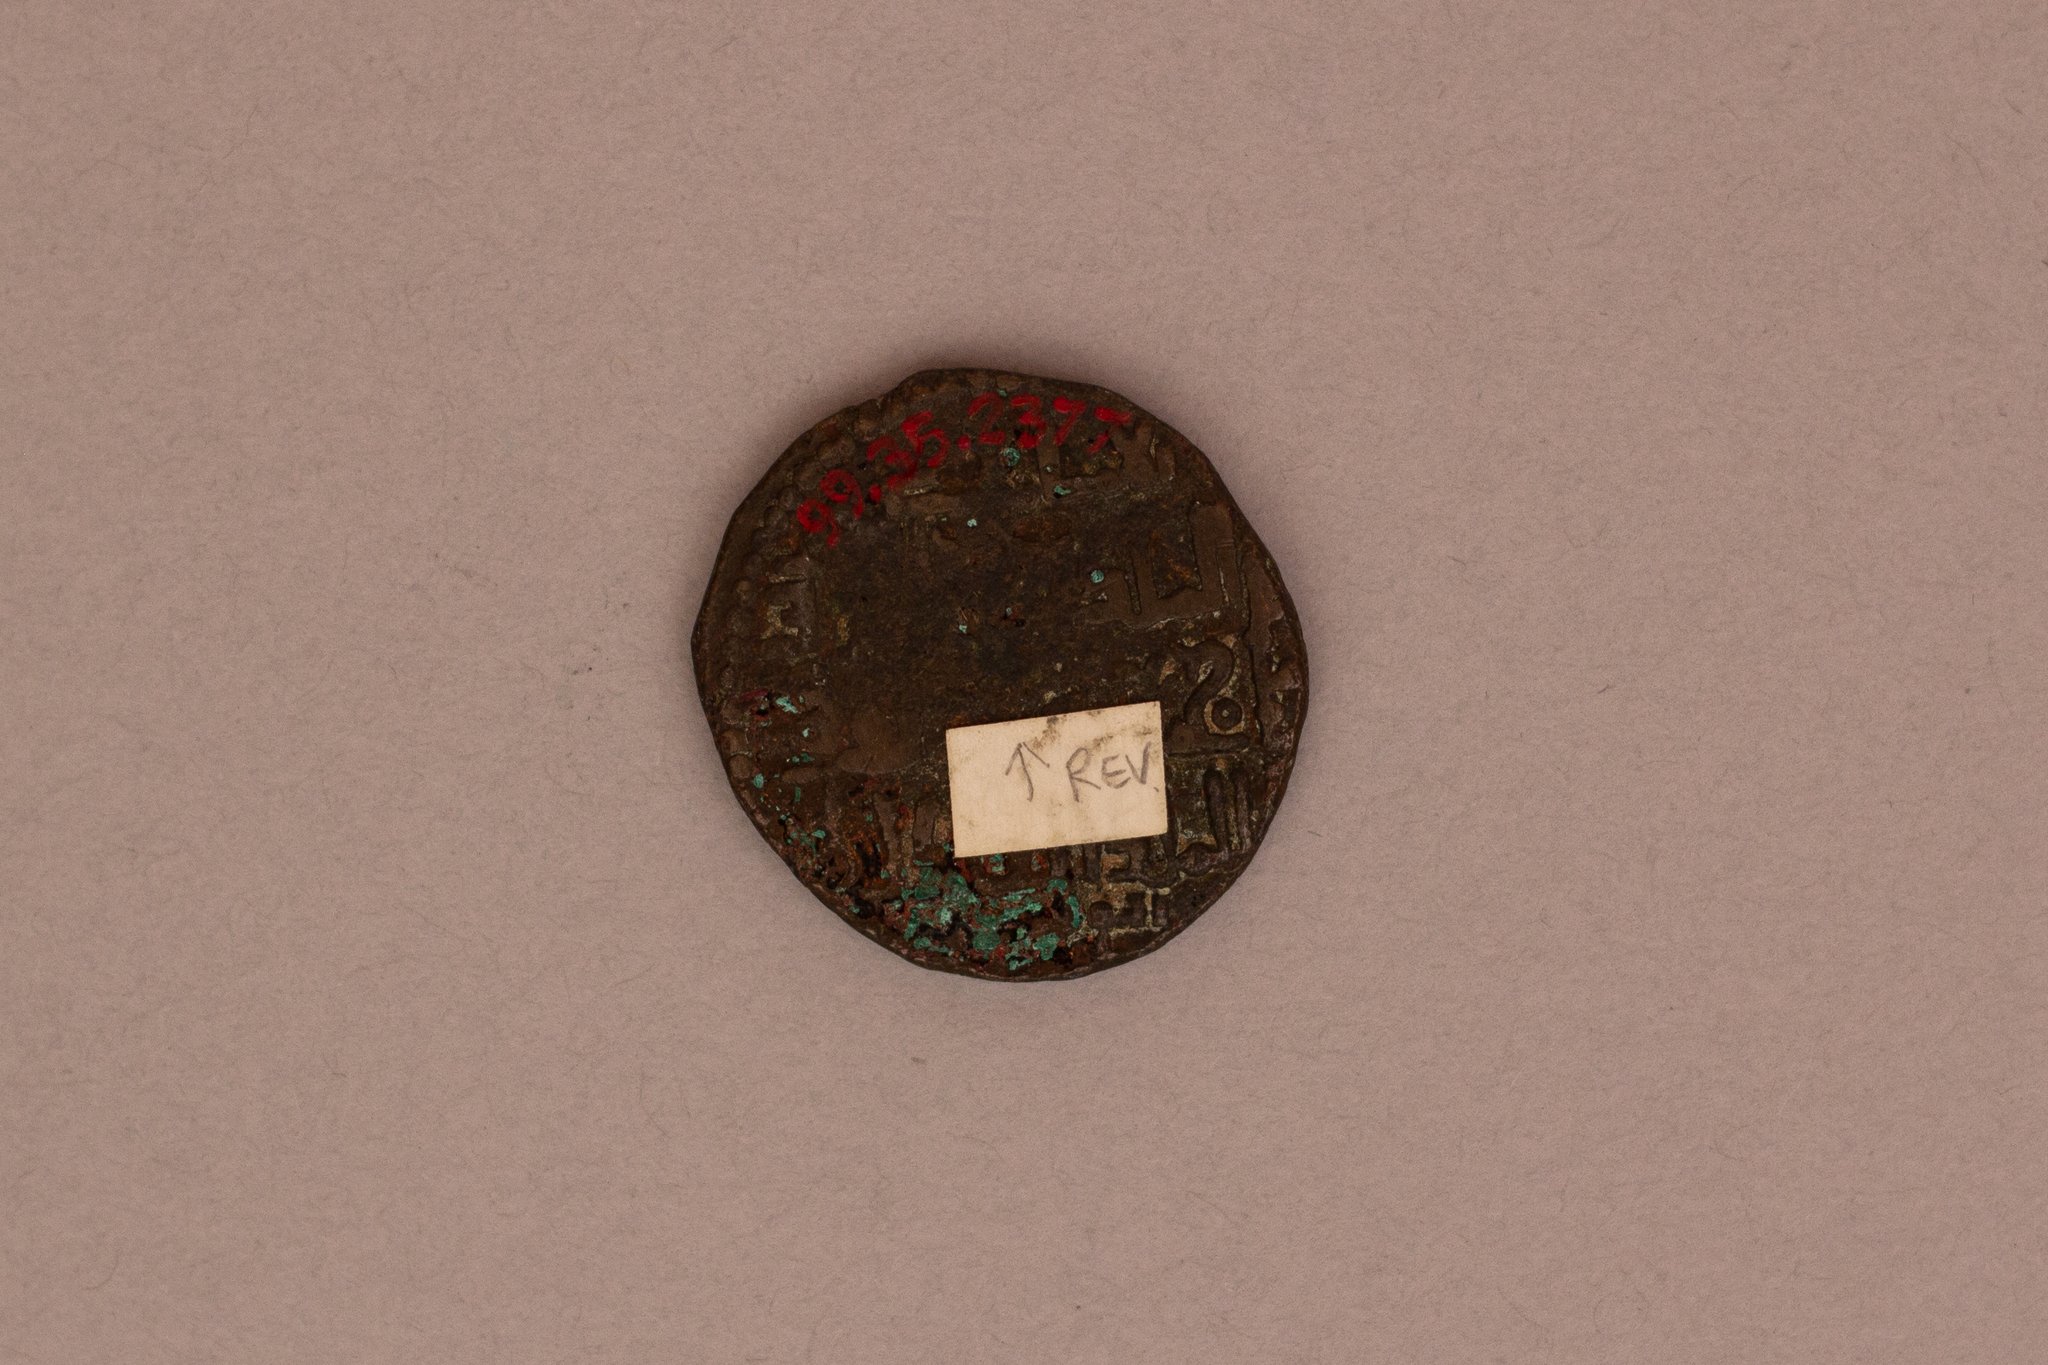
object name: coin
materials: copper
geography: iraq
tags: birds